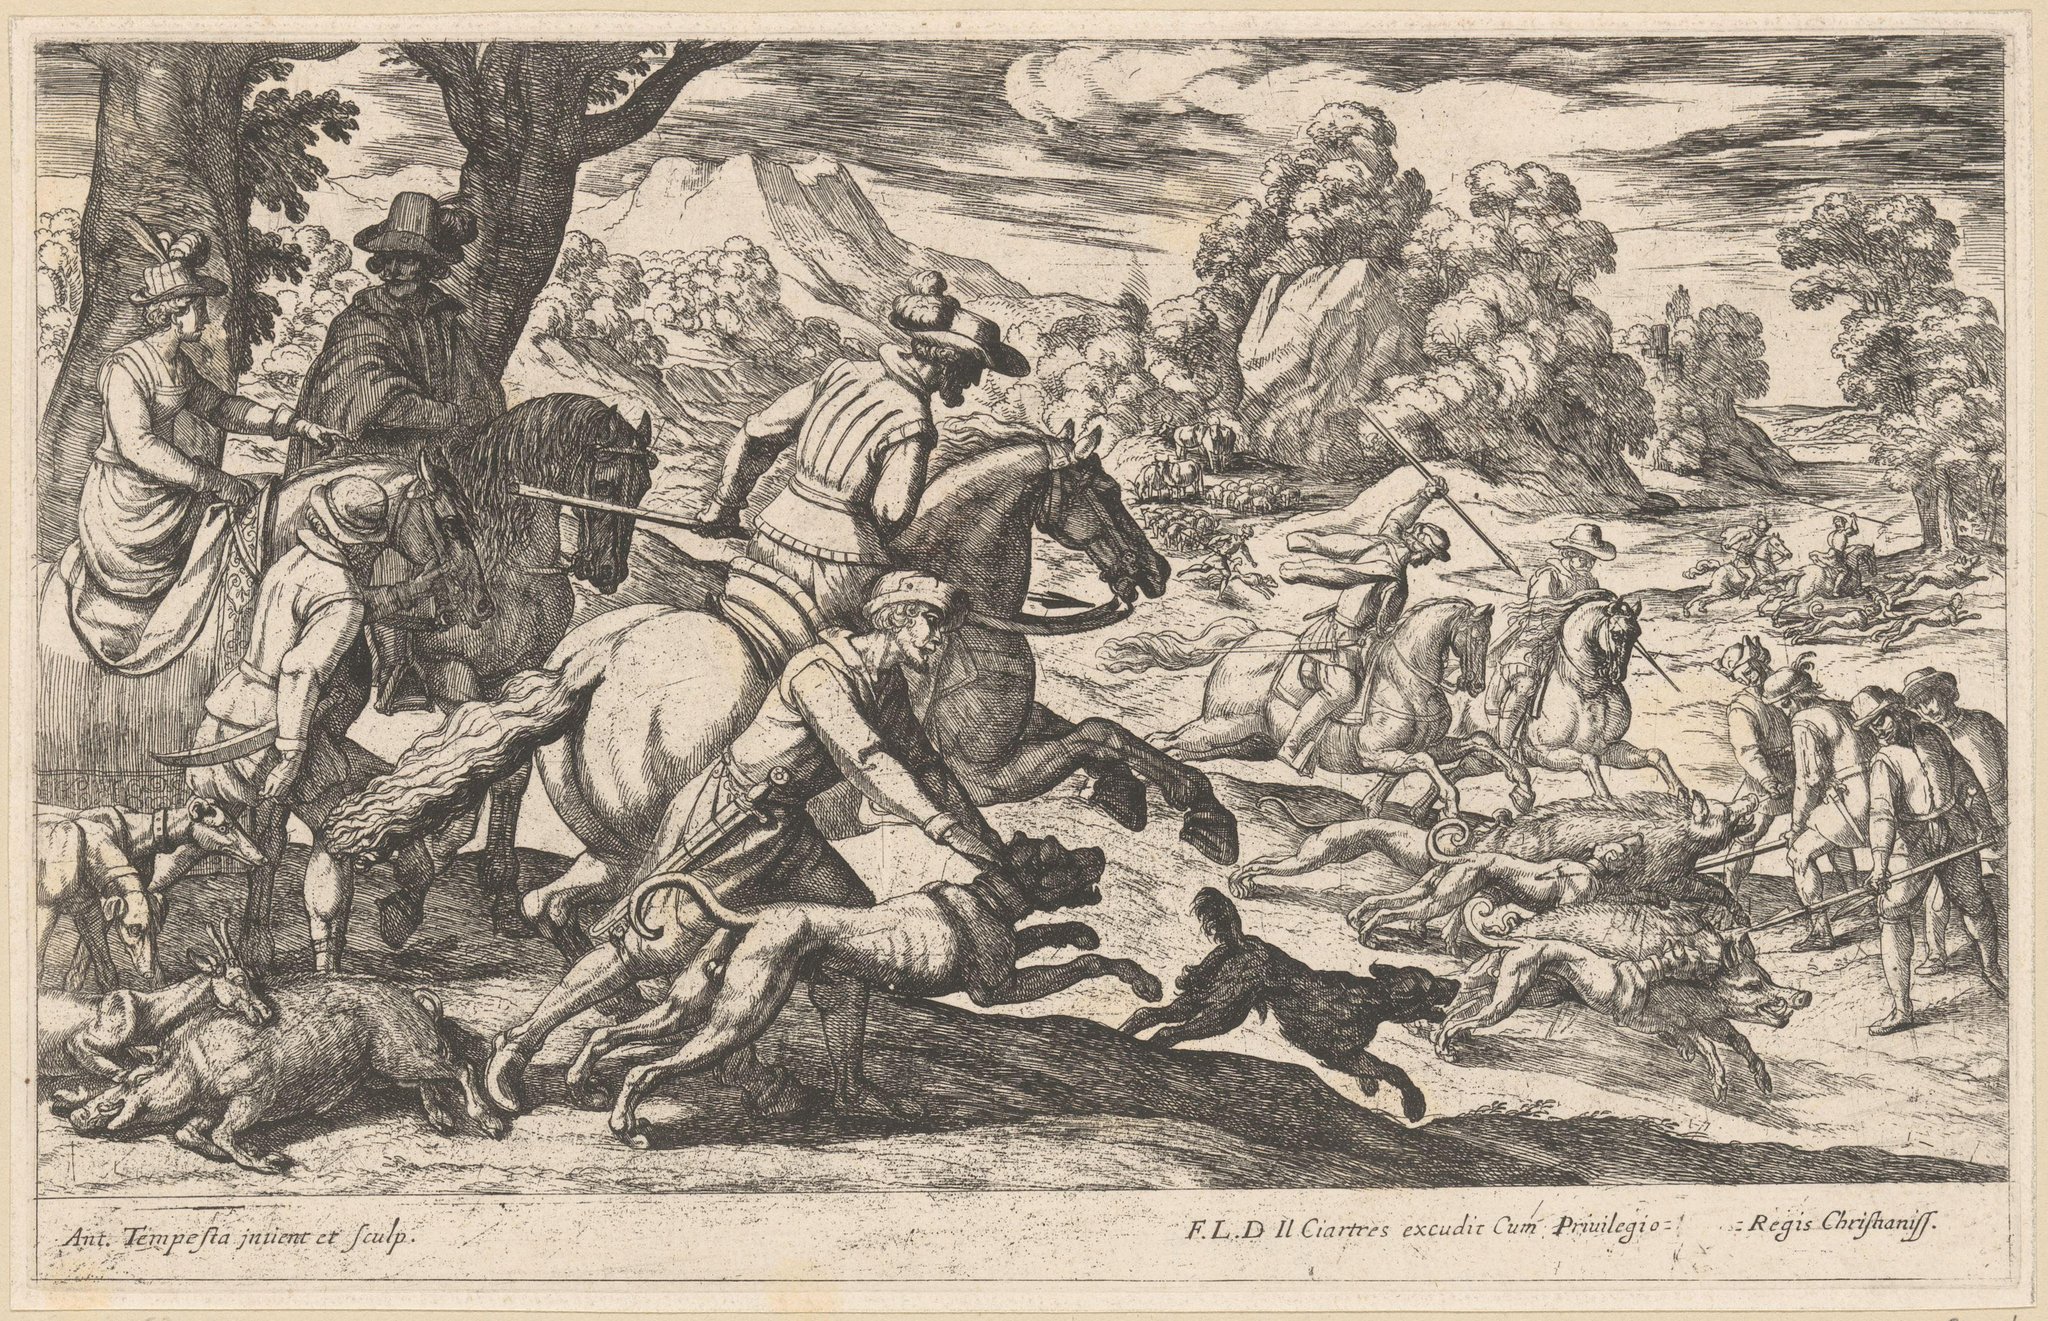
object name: print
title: Jacht op everzwijnen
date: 1600-1620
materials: paper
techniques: etching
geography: italy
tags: boar-hunting, hunter, hunters hunting (n.b.: in 1988-1990 this notation denoted the concept of 43c11421 'hunters resting during the hunt')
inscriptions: collector's mark: Lugt 240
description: Deze prent maakt deel uit van een reeks van zeven prenten met jachtscènes.